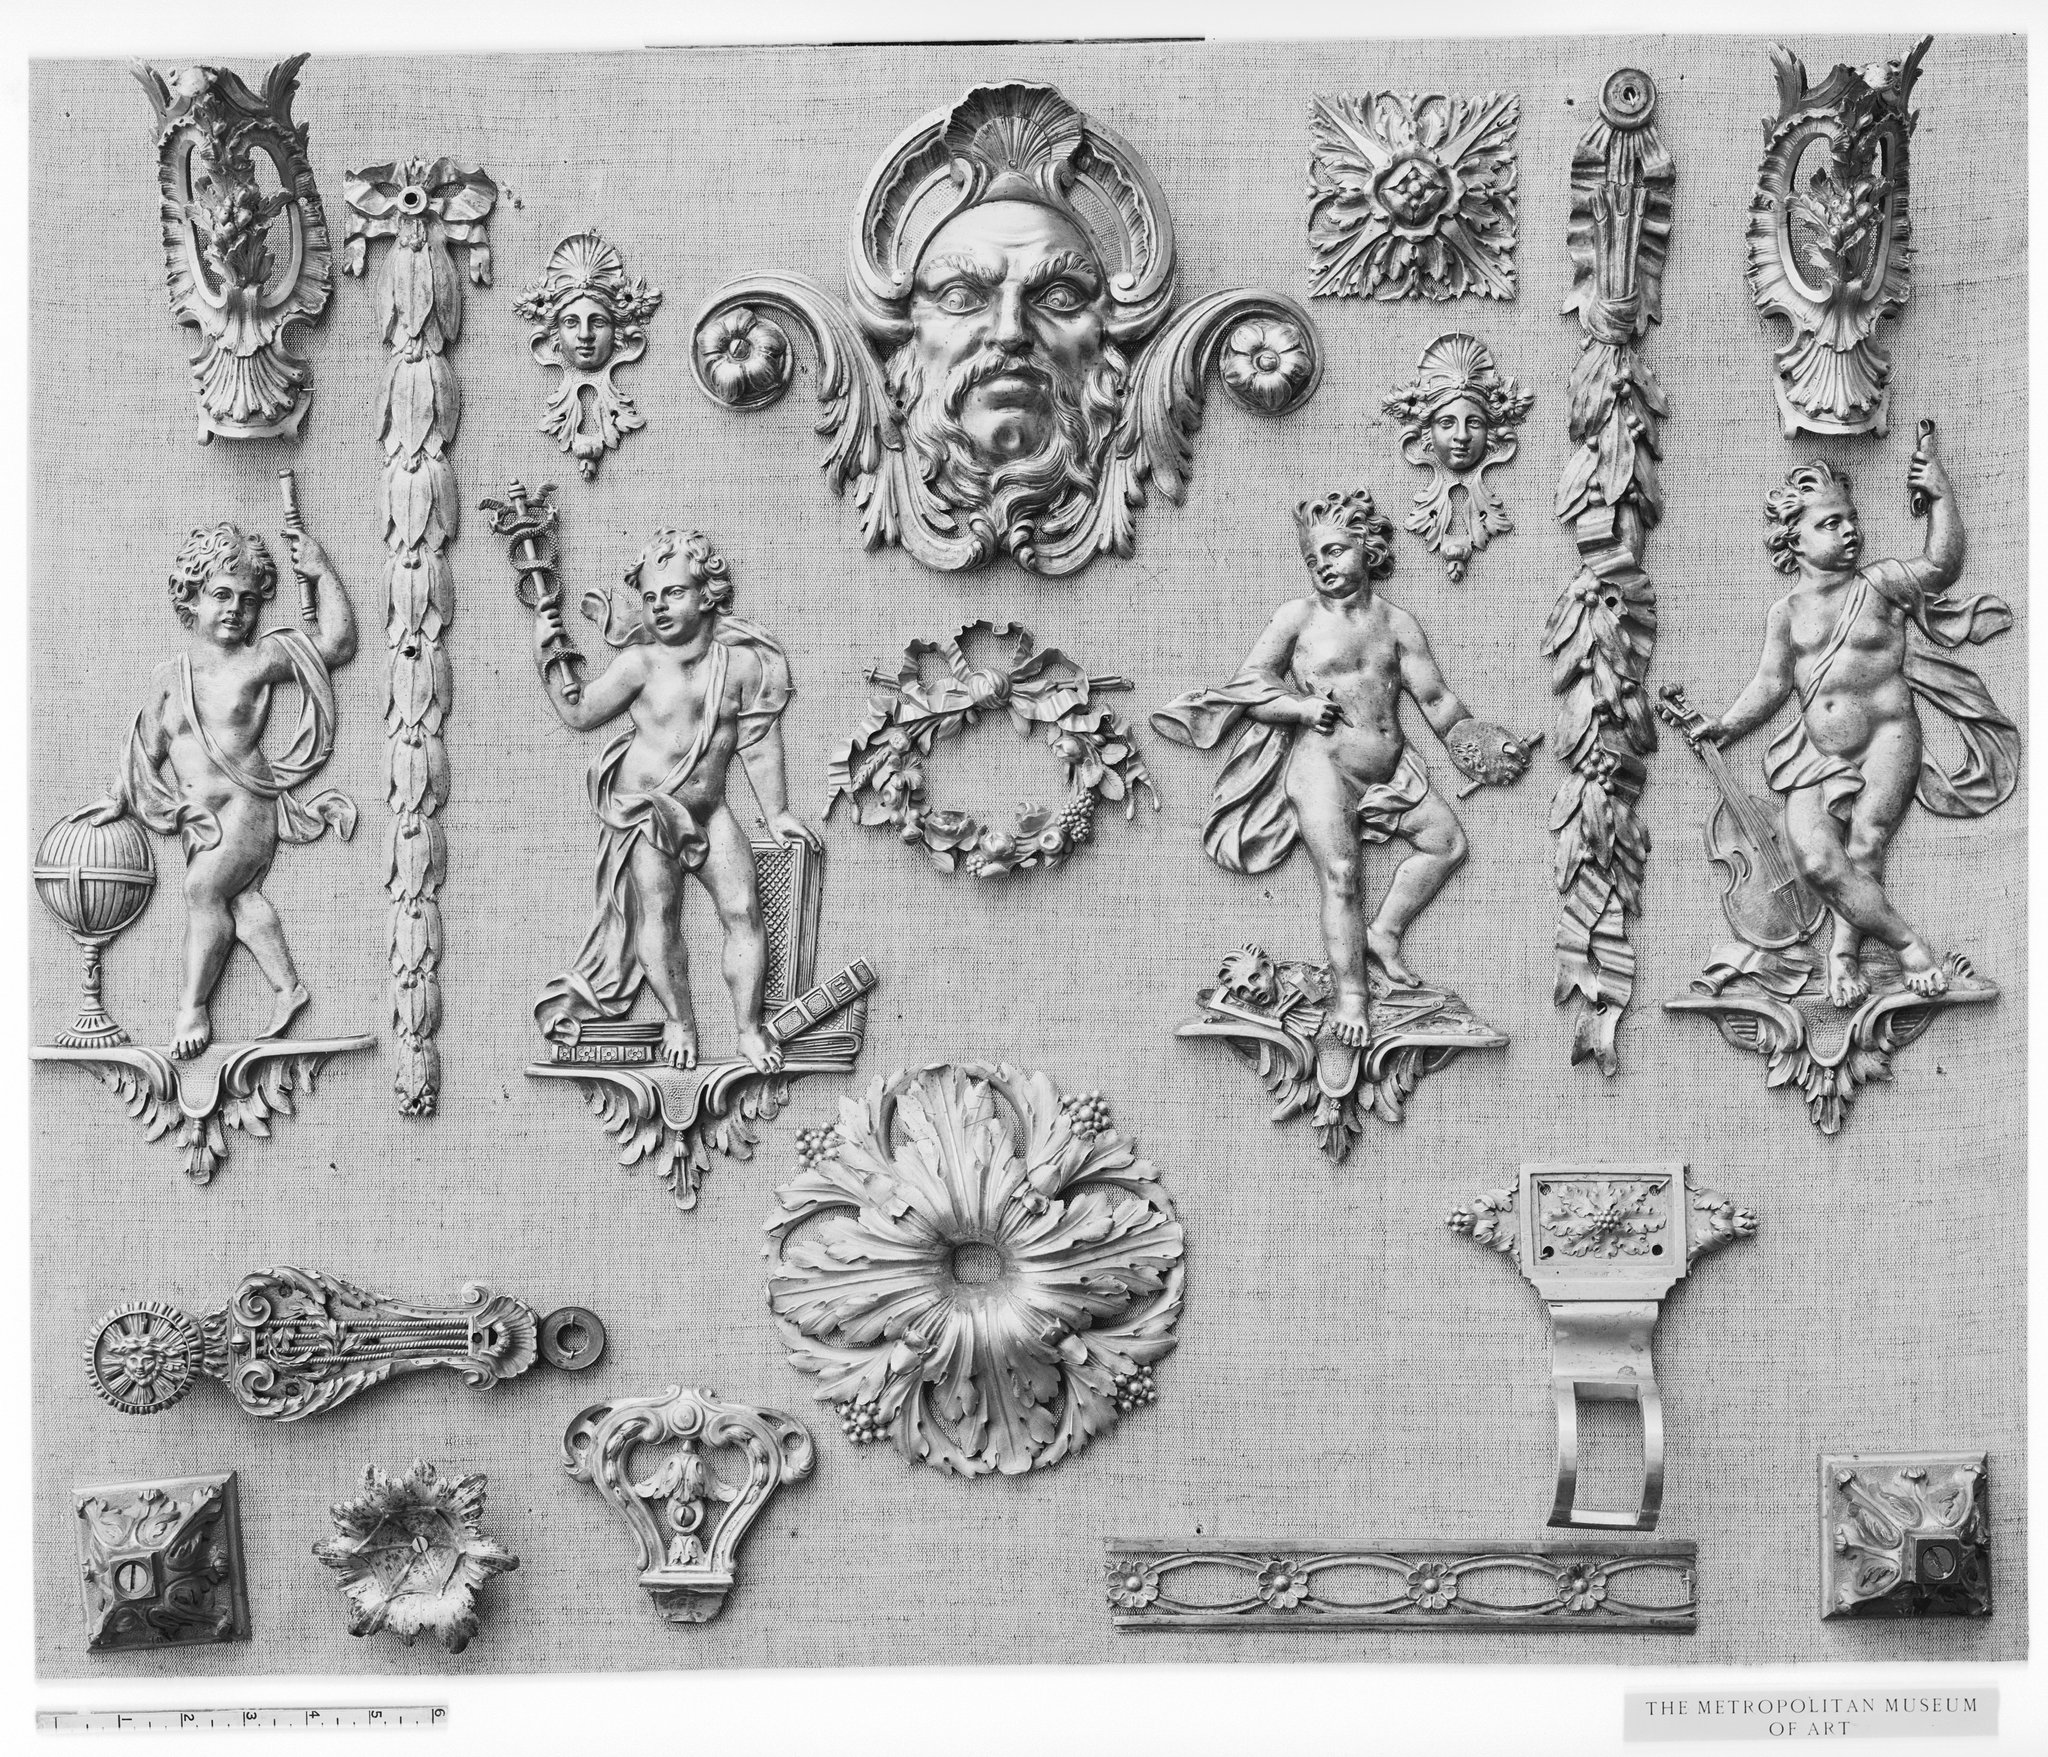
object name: panel ornament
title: Set of four panel ornaments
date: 1601-1800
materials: gilt bronze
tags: male nudes